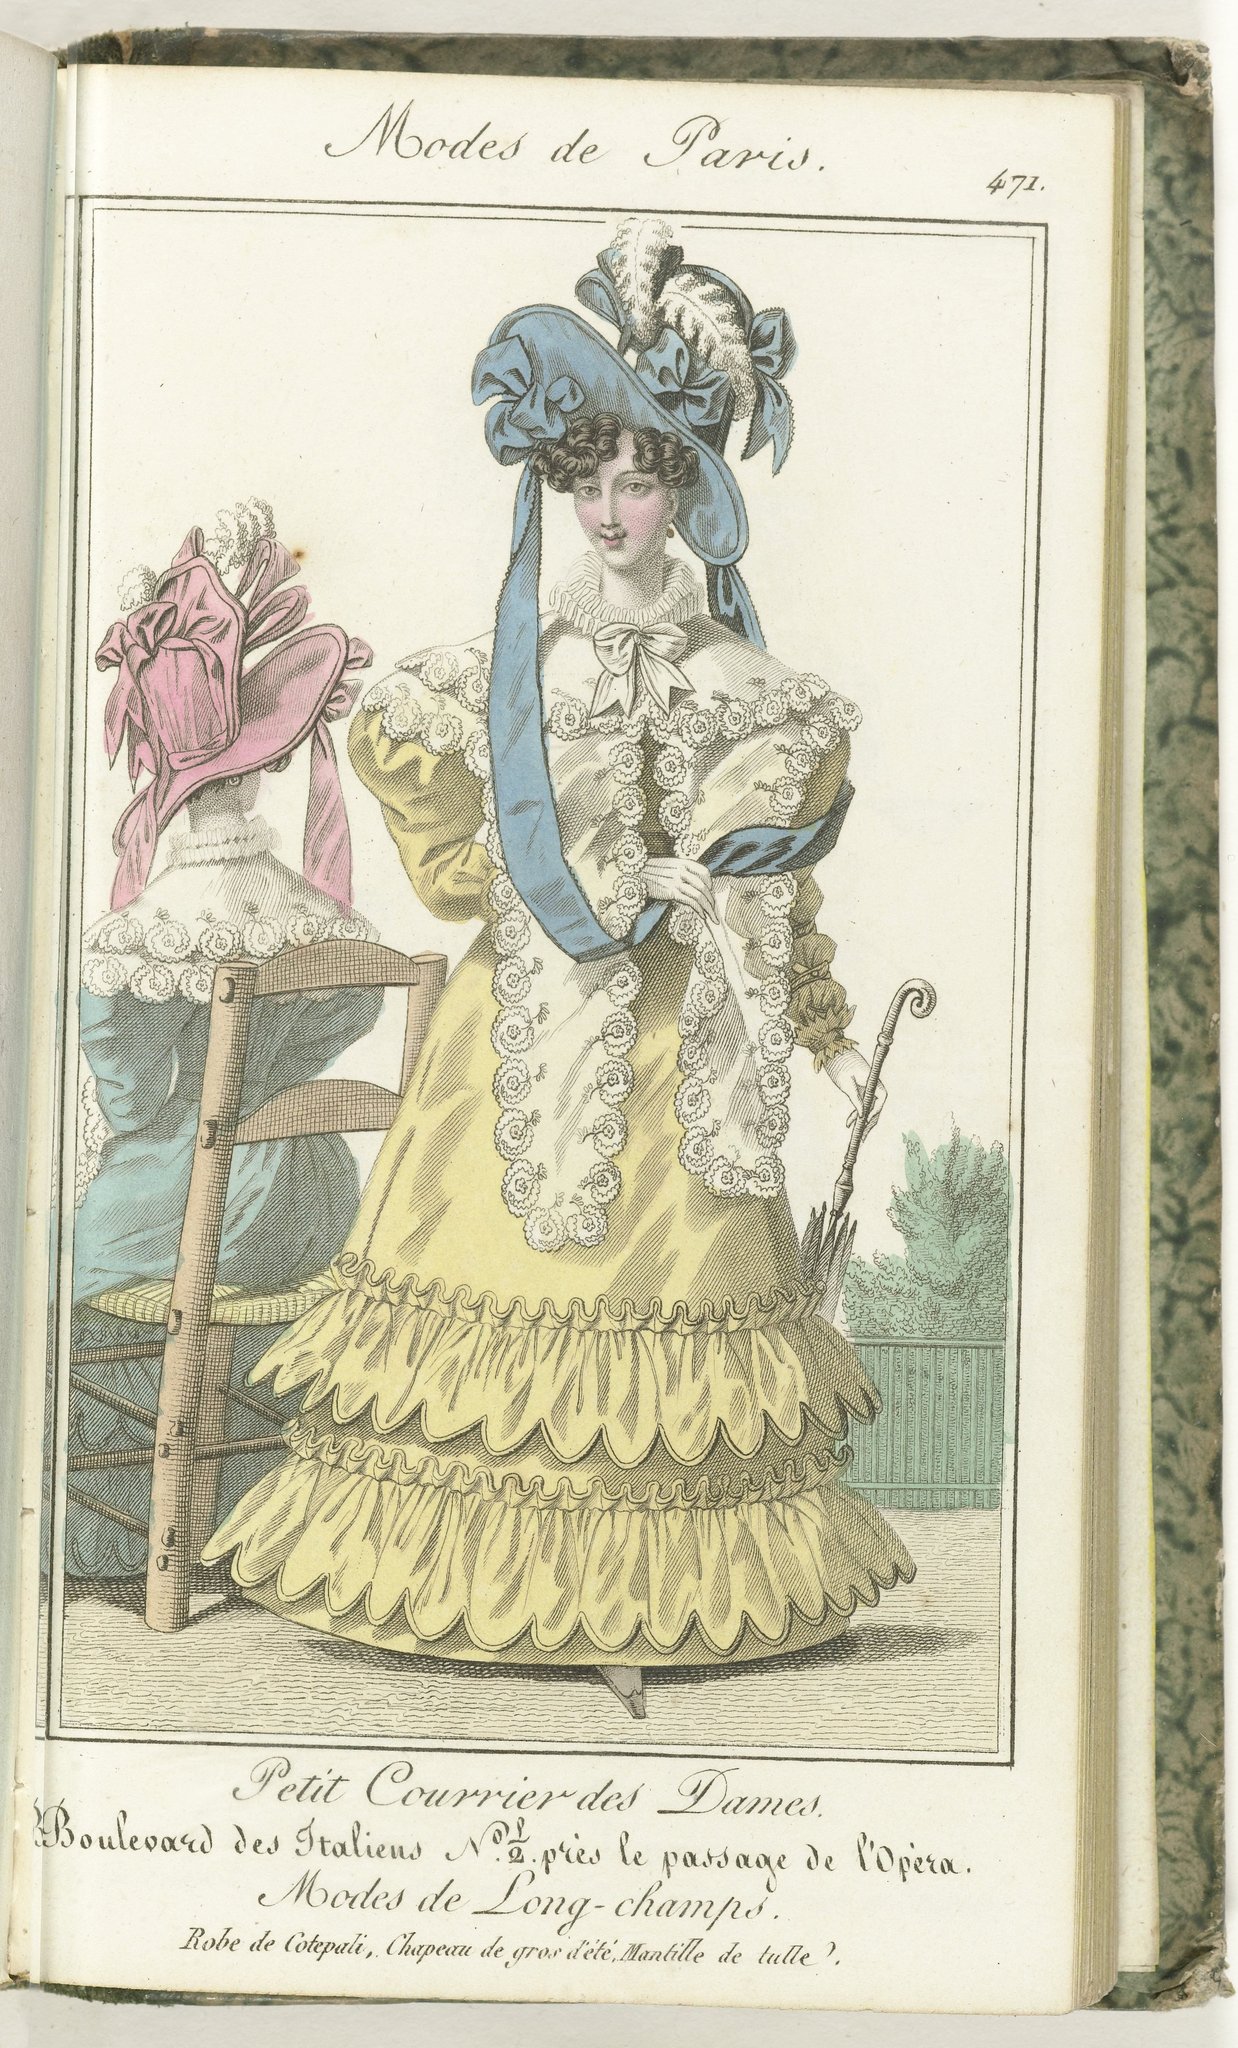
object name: fashion print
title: Petit Courrier des Dames, 20 mai 1827, No. 471 : Modes de Long-Champs...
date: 1827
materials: paper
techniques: engraving, hand coloring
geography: paris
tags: clothing for the upper part of the body (mantelet) (+ women's clothes), fashion plates, head-gear: hat (+ women's clothes), dress, gown (+ women's clothes), parasol, sunshade (+ women's clothes)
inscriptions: title: ‘Petit Courrier des Dames.’, address: ‘Boulevard des Italiens No.2 près le passage de l'Opèra.’, title: ‘Modes de Paris.’, caption: ‘Modes de Long-champs. Robe de Cotepali, Chapeau de gros d'été. Mantille de tulle.’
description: 'Modes de Long-champs.' Staande vrouw gekleed in een japon van cotepali. Op het hoofd een hoed van 'gros d'été'. Mantille van tule. Parasol in de hand. Links een zittende vrouw, op de rug gezien, gekleed in eenzelfde japon. Prent uit het modetijdschrift Petit Courrier des Dames (1821-1868). Ingebonden (met enkele pp. Le Journal des Dames et des Modes). 15 Januari 1827 t/m 20 maart 1830. Incompleet.